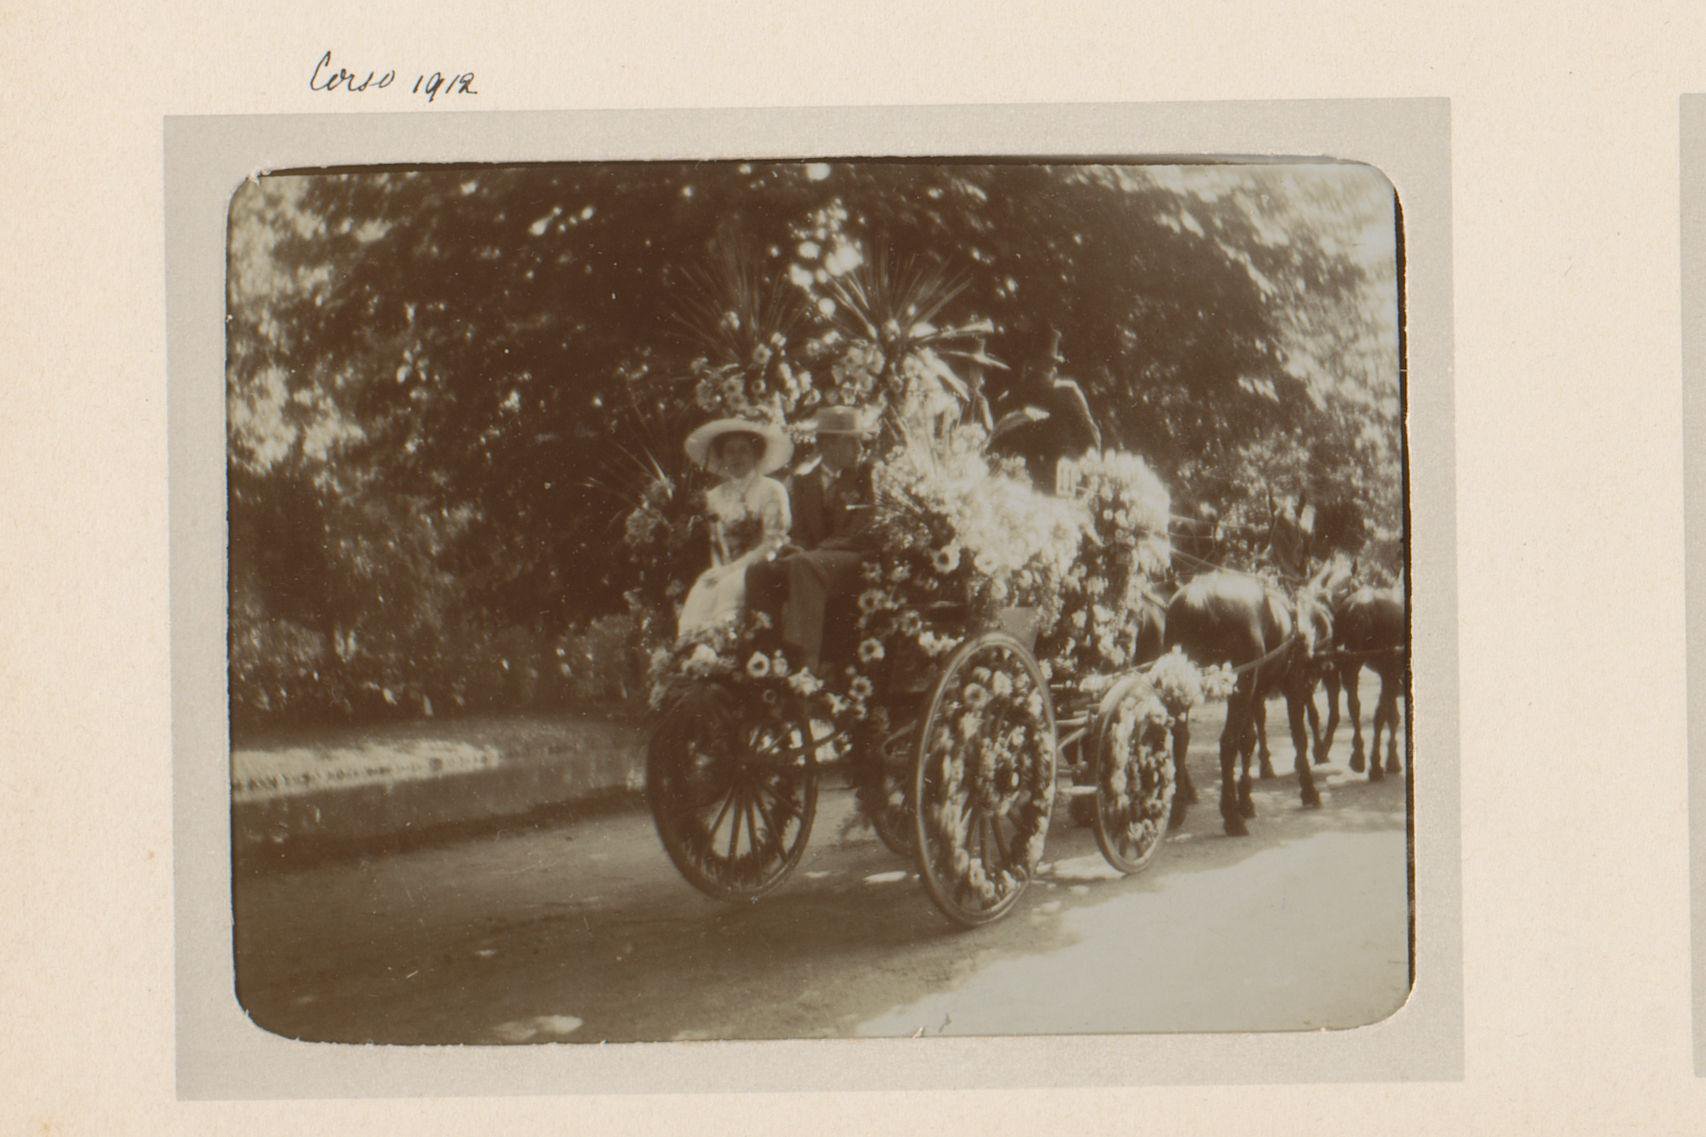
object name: album leaf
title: Praalwagen tijdens het bloemencorso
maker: liesbeth overhoff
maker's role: fotograaf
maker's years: 1895-1969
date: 1912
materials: paper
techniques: gelatin silver print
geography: bollenstreek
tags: public festivities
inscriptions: inscription: ‘Corso 1912’